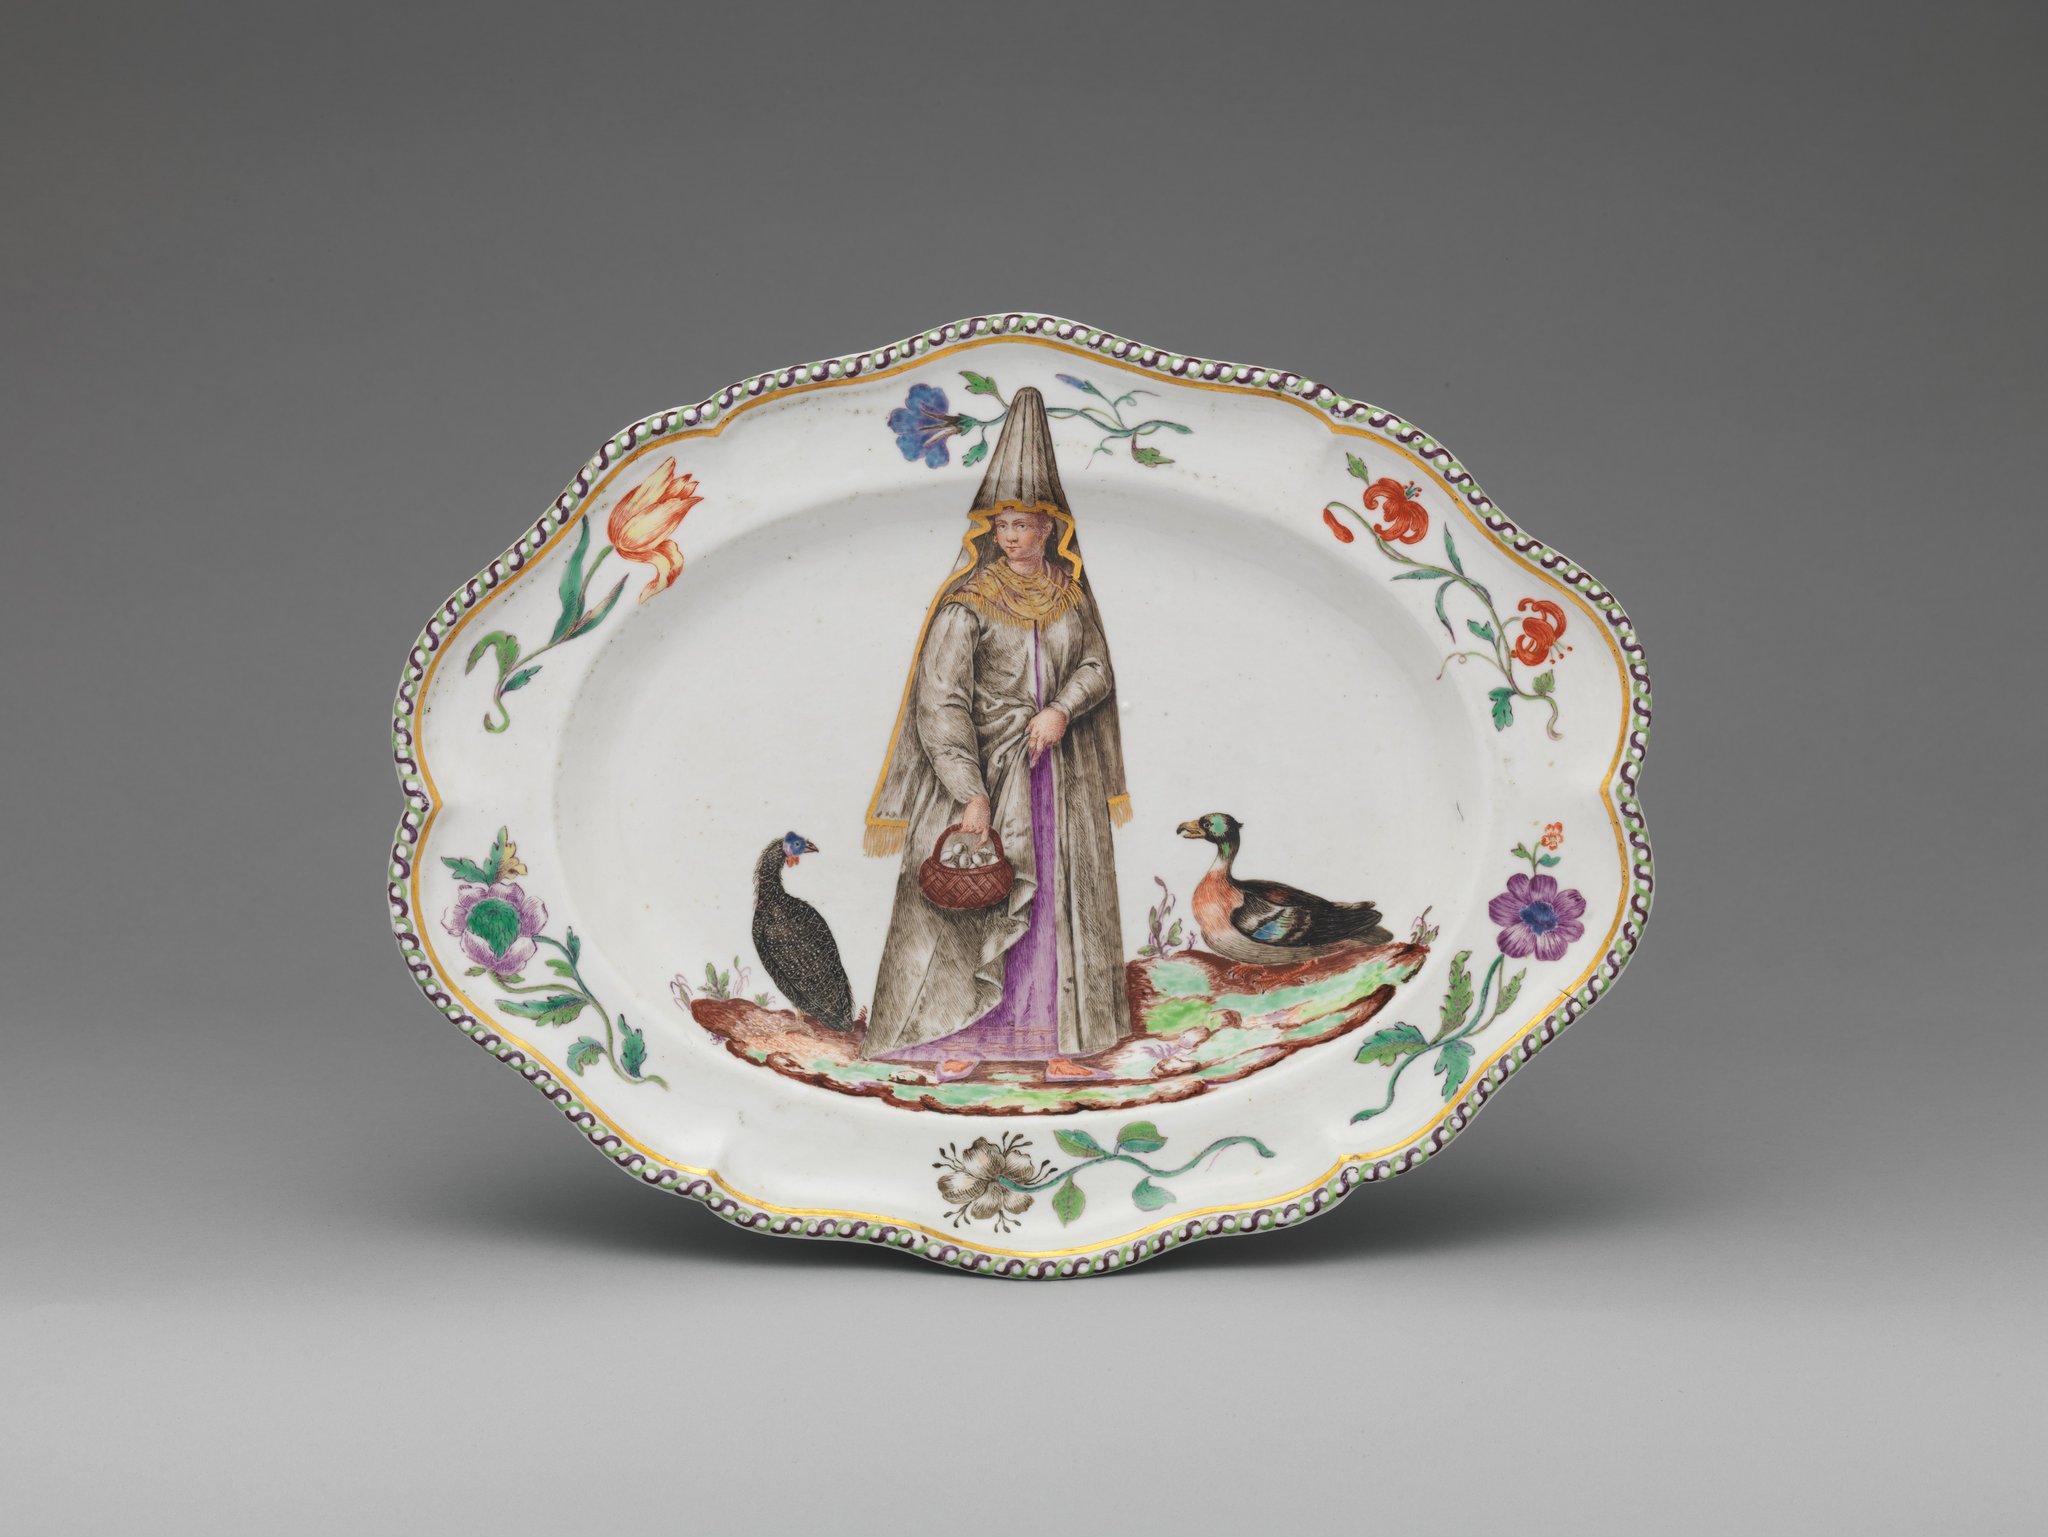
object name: tray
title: Tray (one of a set)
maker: doccia porcelain manufactory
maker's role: manufactory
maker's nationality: italian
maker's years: 1737-1896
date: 1745-1747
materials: enamel, gold, hard paste porcelain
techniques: polychrome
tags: birds,women,flowers,eggs